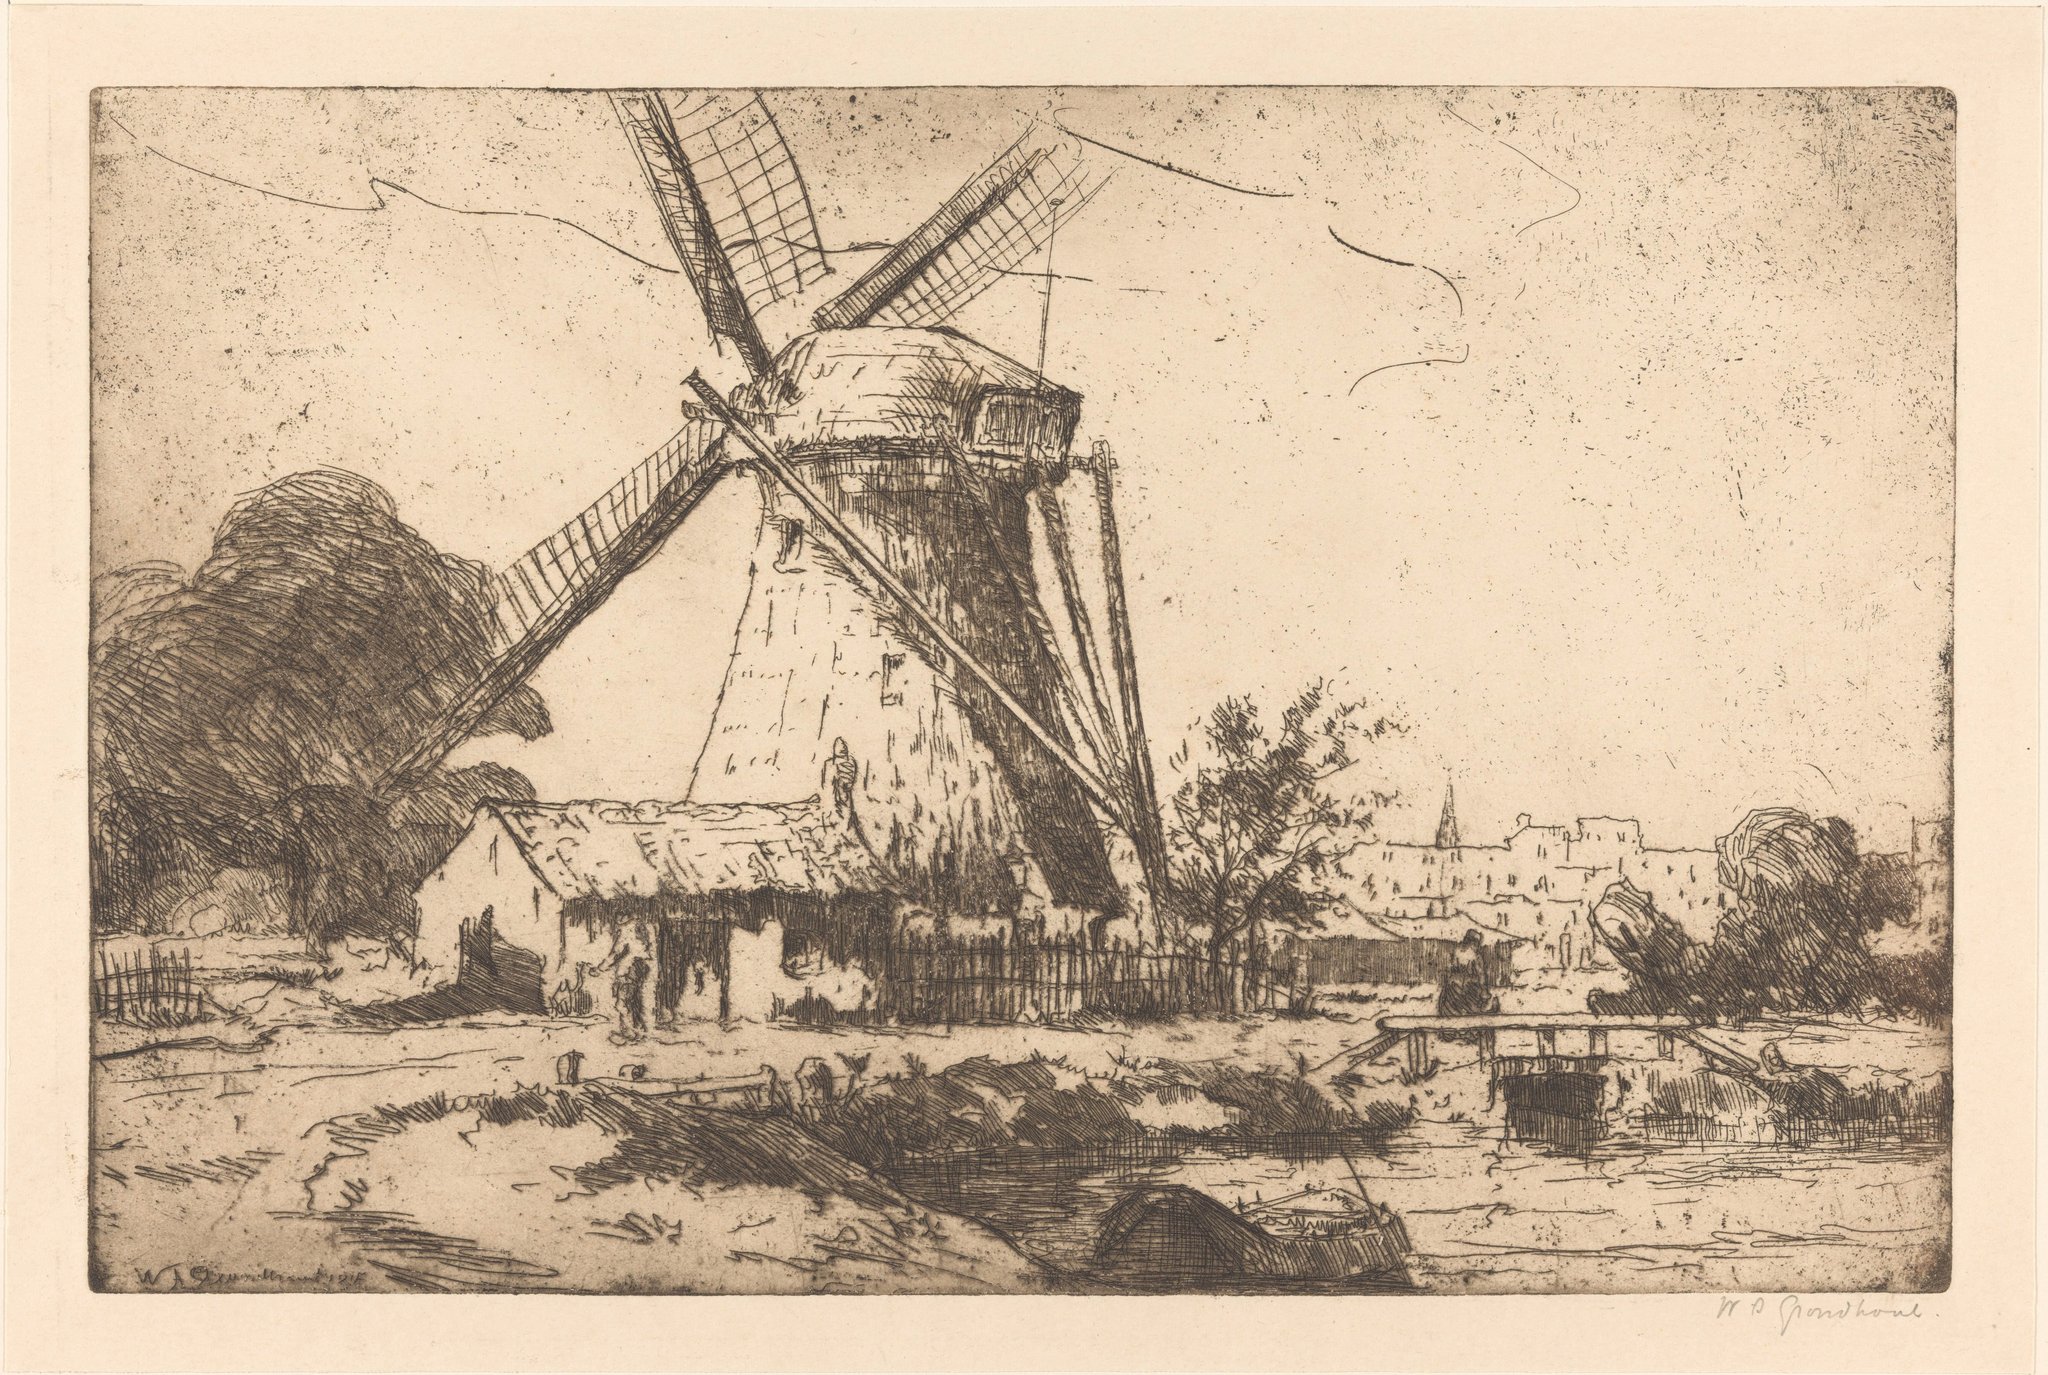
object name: print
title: Molen bij Den Haag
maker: willem adrianus grondhout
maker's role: draughtsman, painter, print maker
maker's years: 1878-1934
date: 1915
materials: paper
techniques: etching, intaglio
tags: windmill in landscape, small canal, ditch, prospect of city, town panorama, silhouette of city, the hague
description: Rechts van de molen een brug over een wetering.